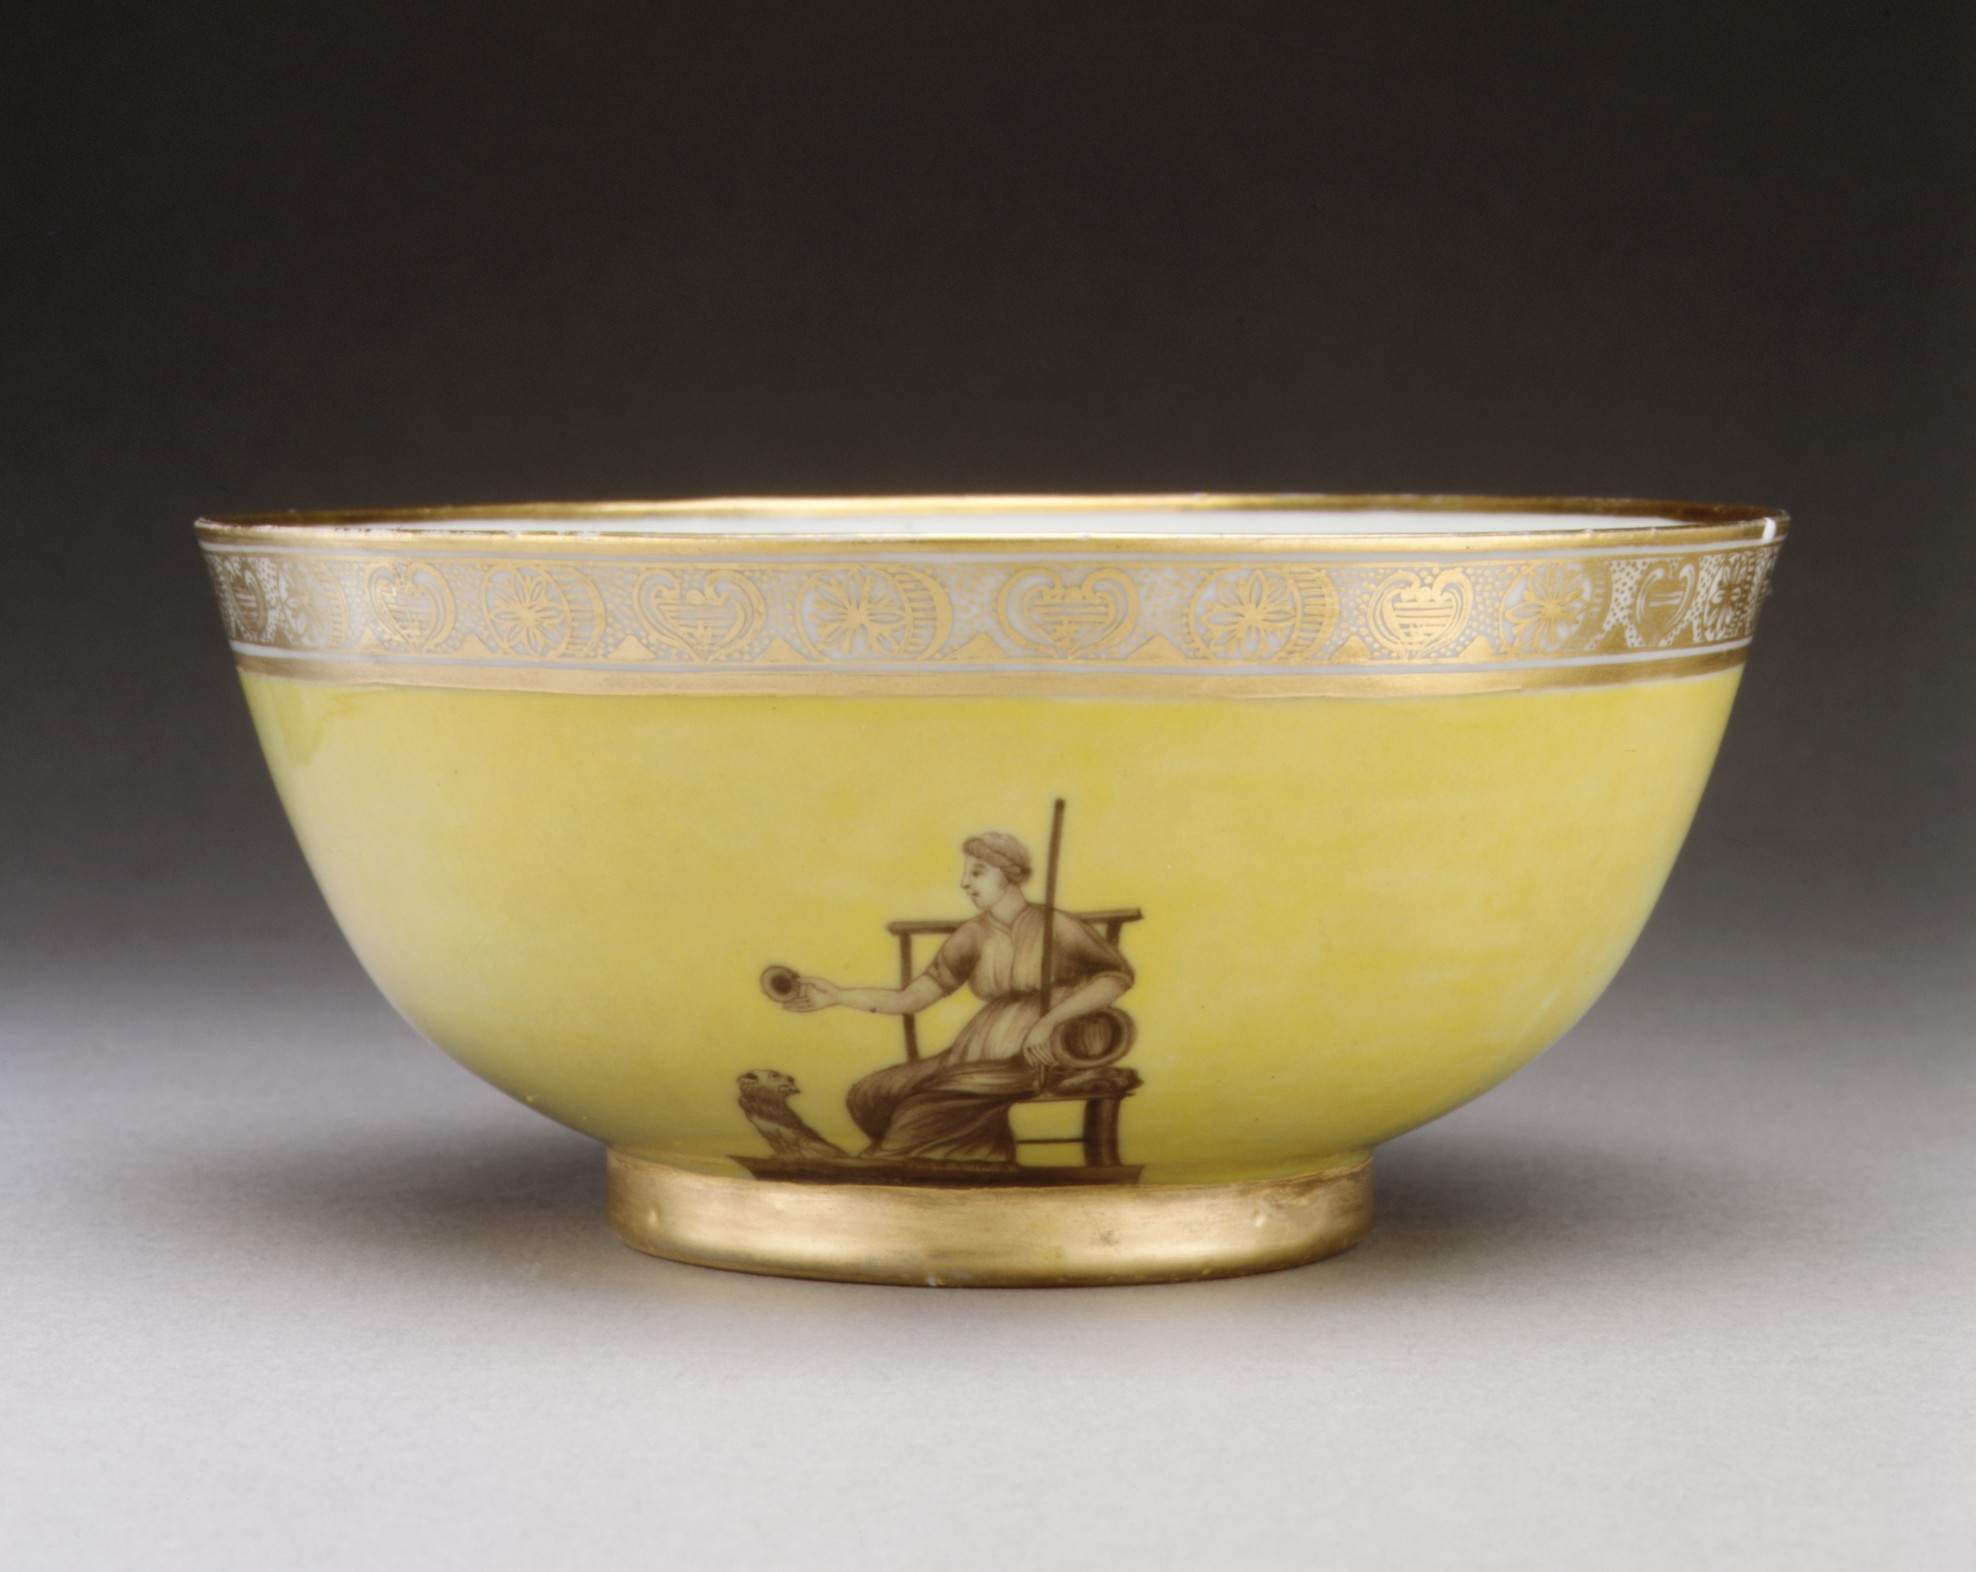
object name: bowl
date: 1811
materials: hard paste porcelain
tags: animals,men